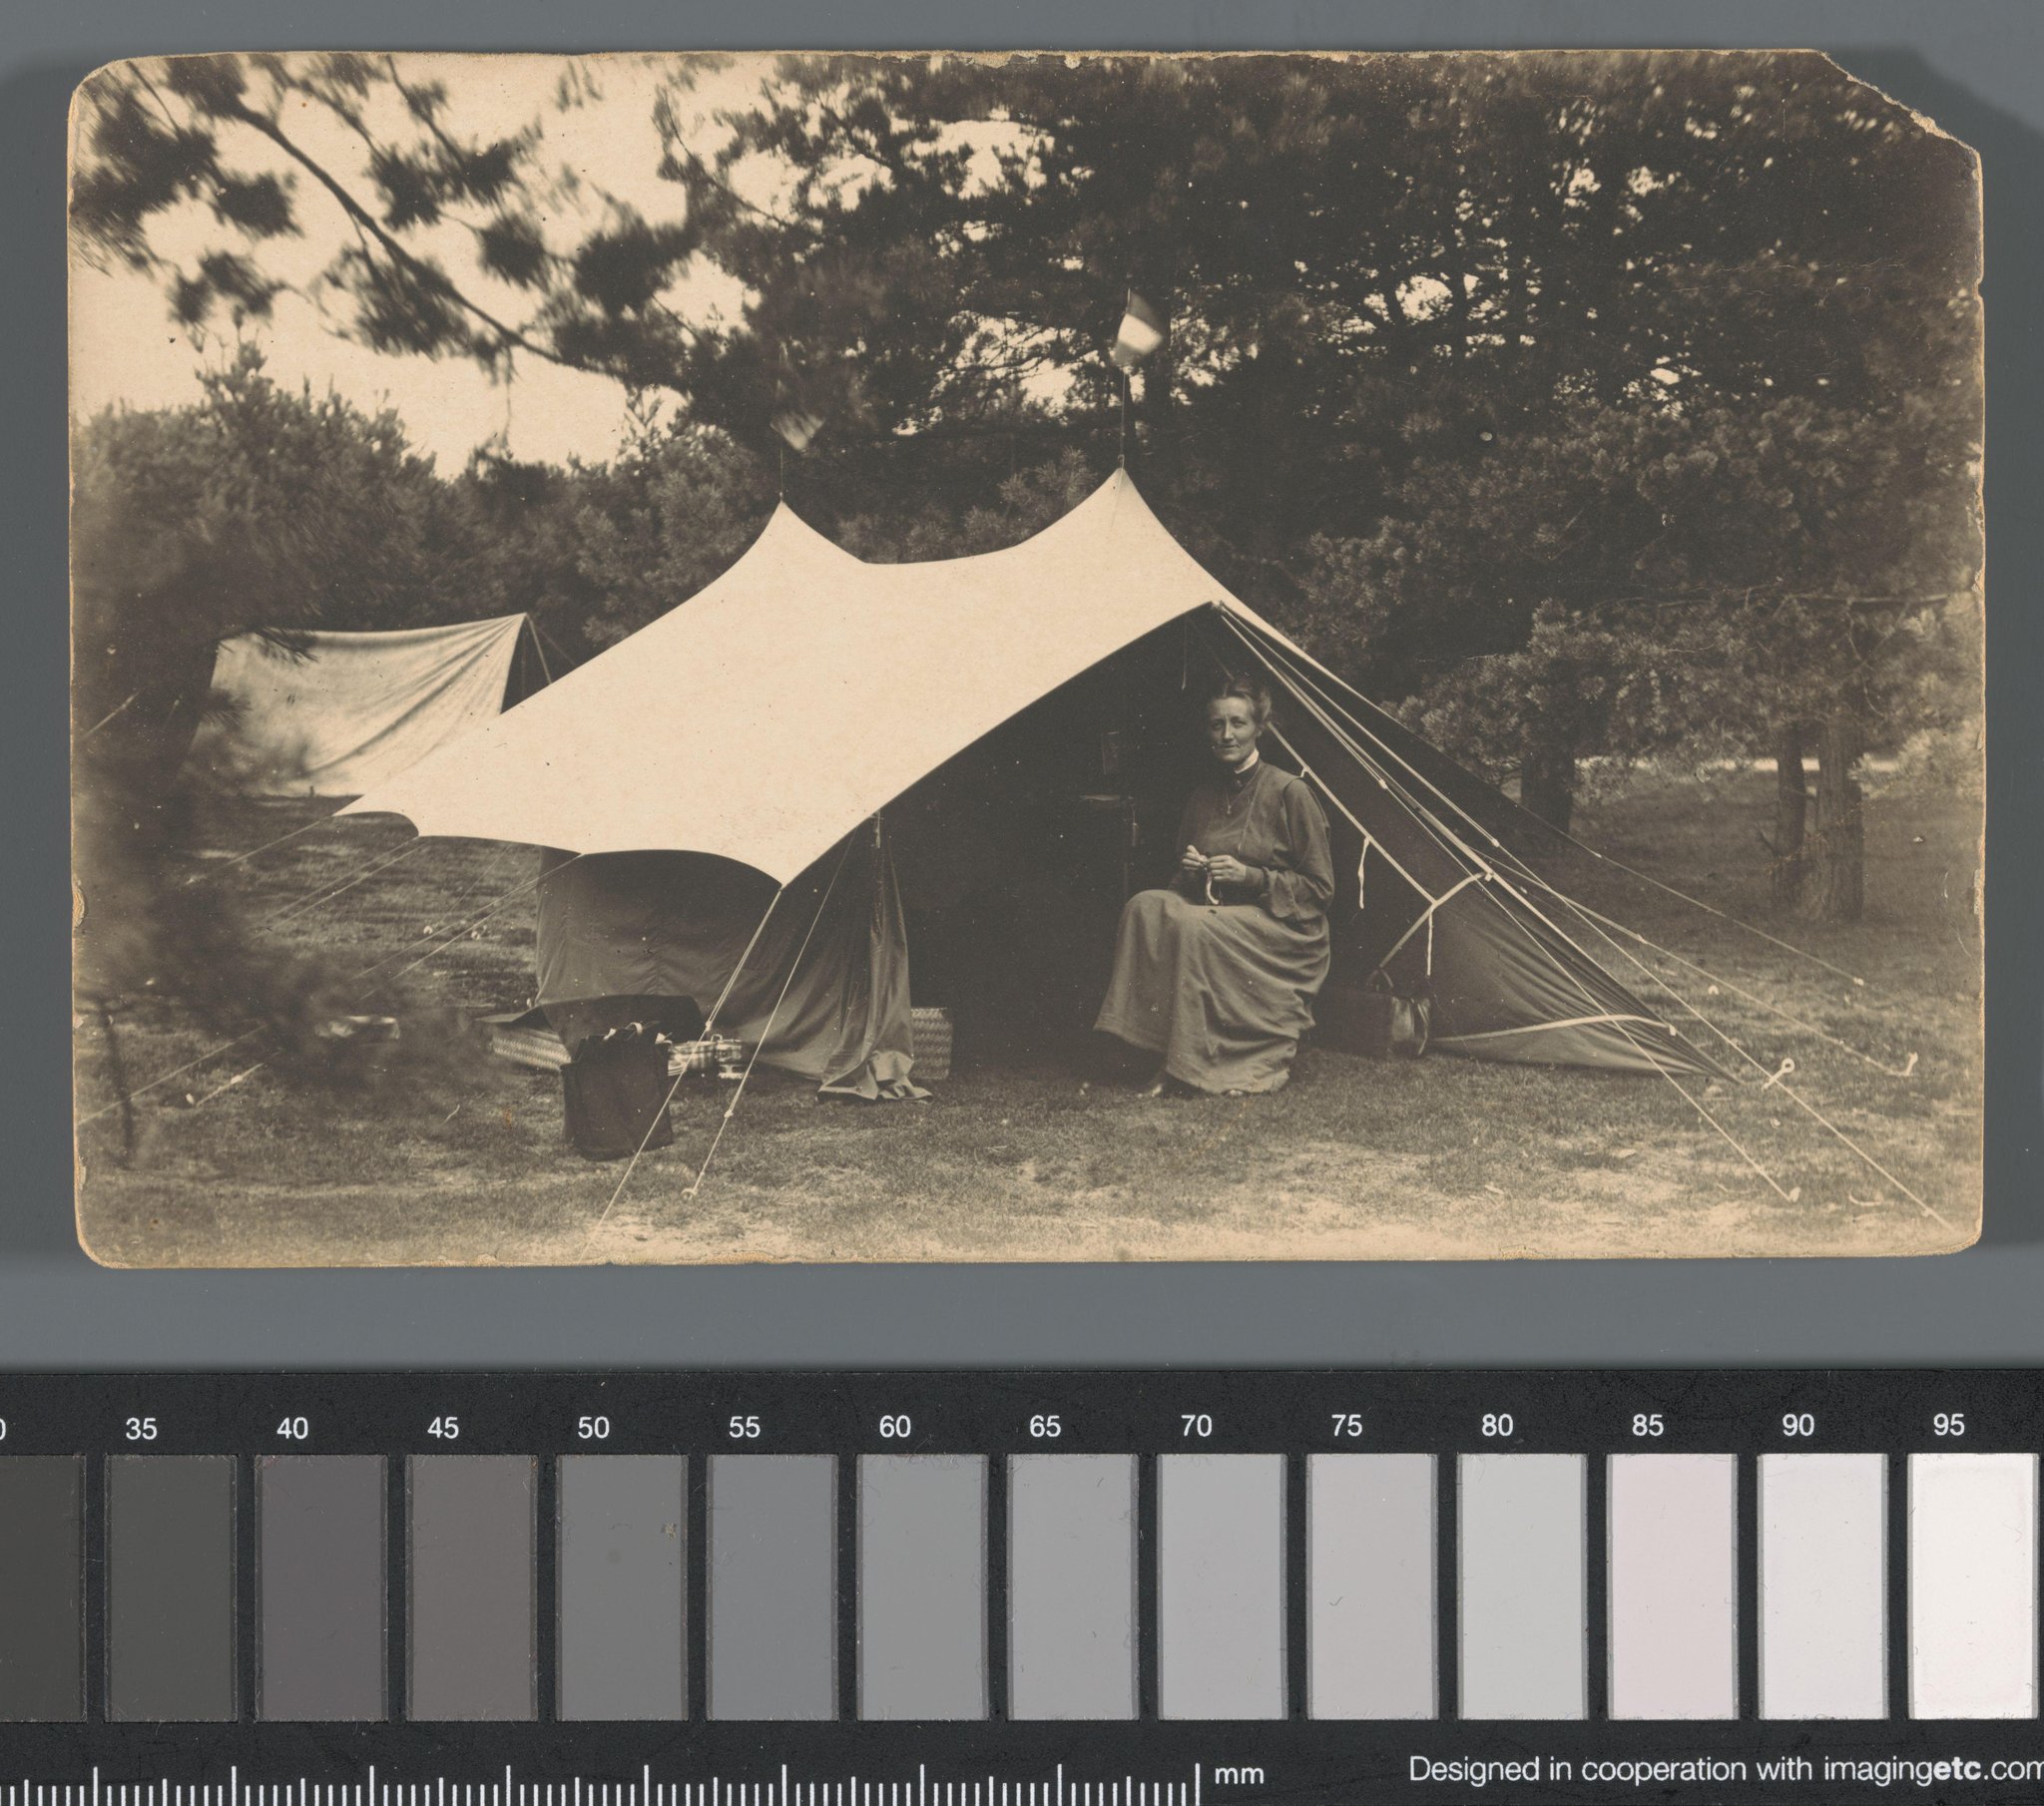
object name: ansichtkaart, prentbriefkaart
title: Portret van een onbekende vrouw voor een tent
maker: Anonymous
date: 1925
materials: photographic support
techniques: gelatin silver print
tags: tent, historical persons not known by name - bb - woman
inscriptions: annotation: ‘Lieve Keetje - deze tent/ kreeg ik van de zusters als afscheids-/ geschenk. ik ben hier nu vanaf eind juli al aan 't kampeeren/ 't is meer dan heerlijk./ Deze week is het ster congres/ en geniet ik van de buitenge/ wone mooie lezingen en/ het interessante gezelschap./ Ik ben zoekend naar een kaartje/ maar vond nog niets. Gaat/ het je goed? Hartelijke groeten van/ u M.’, stamp: ‘HARLINGEN/ 14.VIII.25.112V/ 1’, address: ‘Mej. K. Fontein/ Harlingen/ Voorstraat?’, stamp: ‘SOESTERBERG/ 17. 8. 25.7-8 V./ 1’